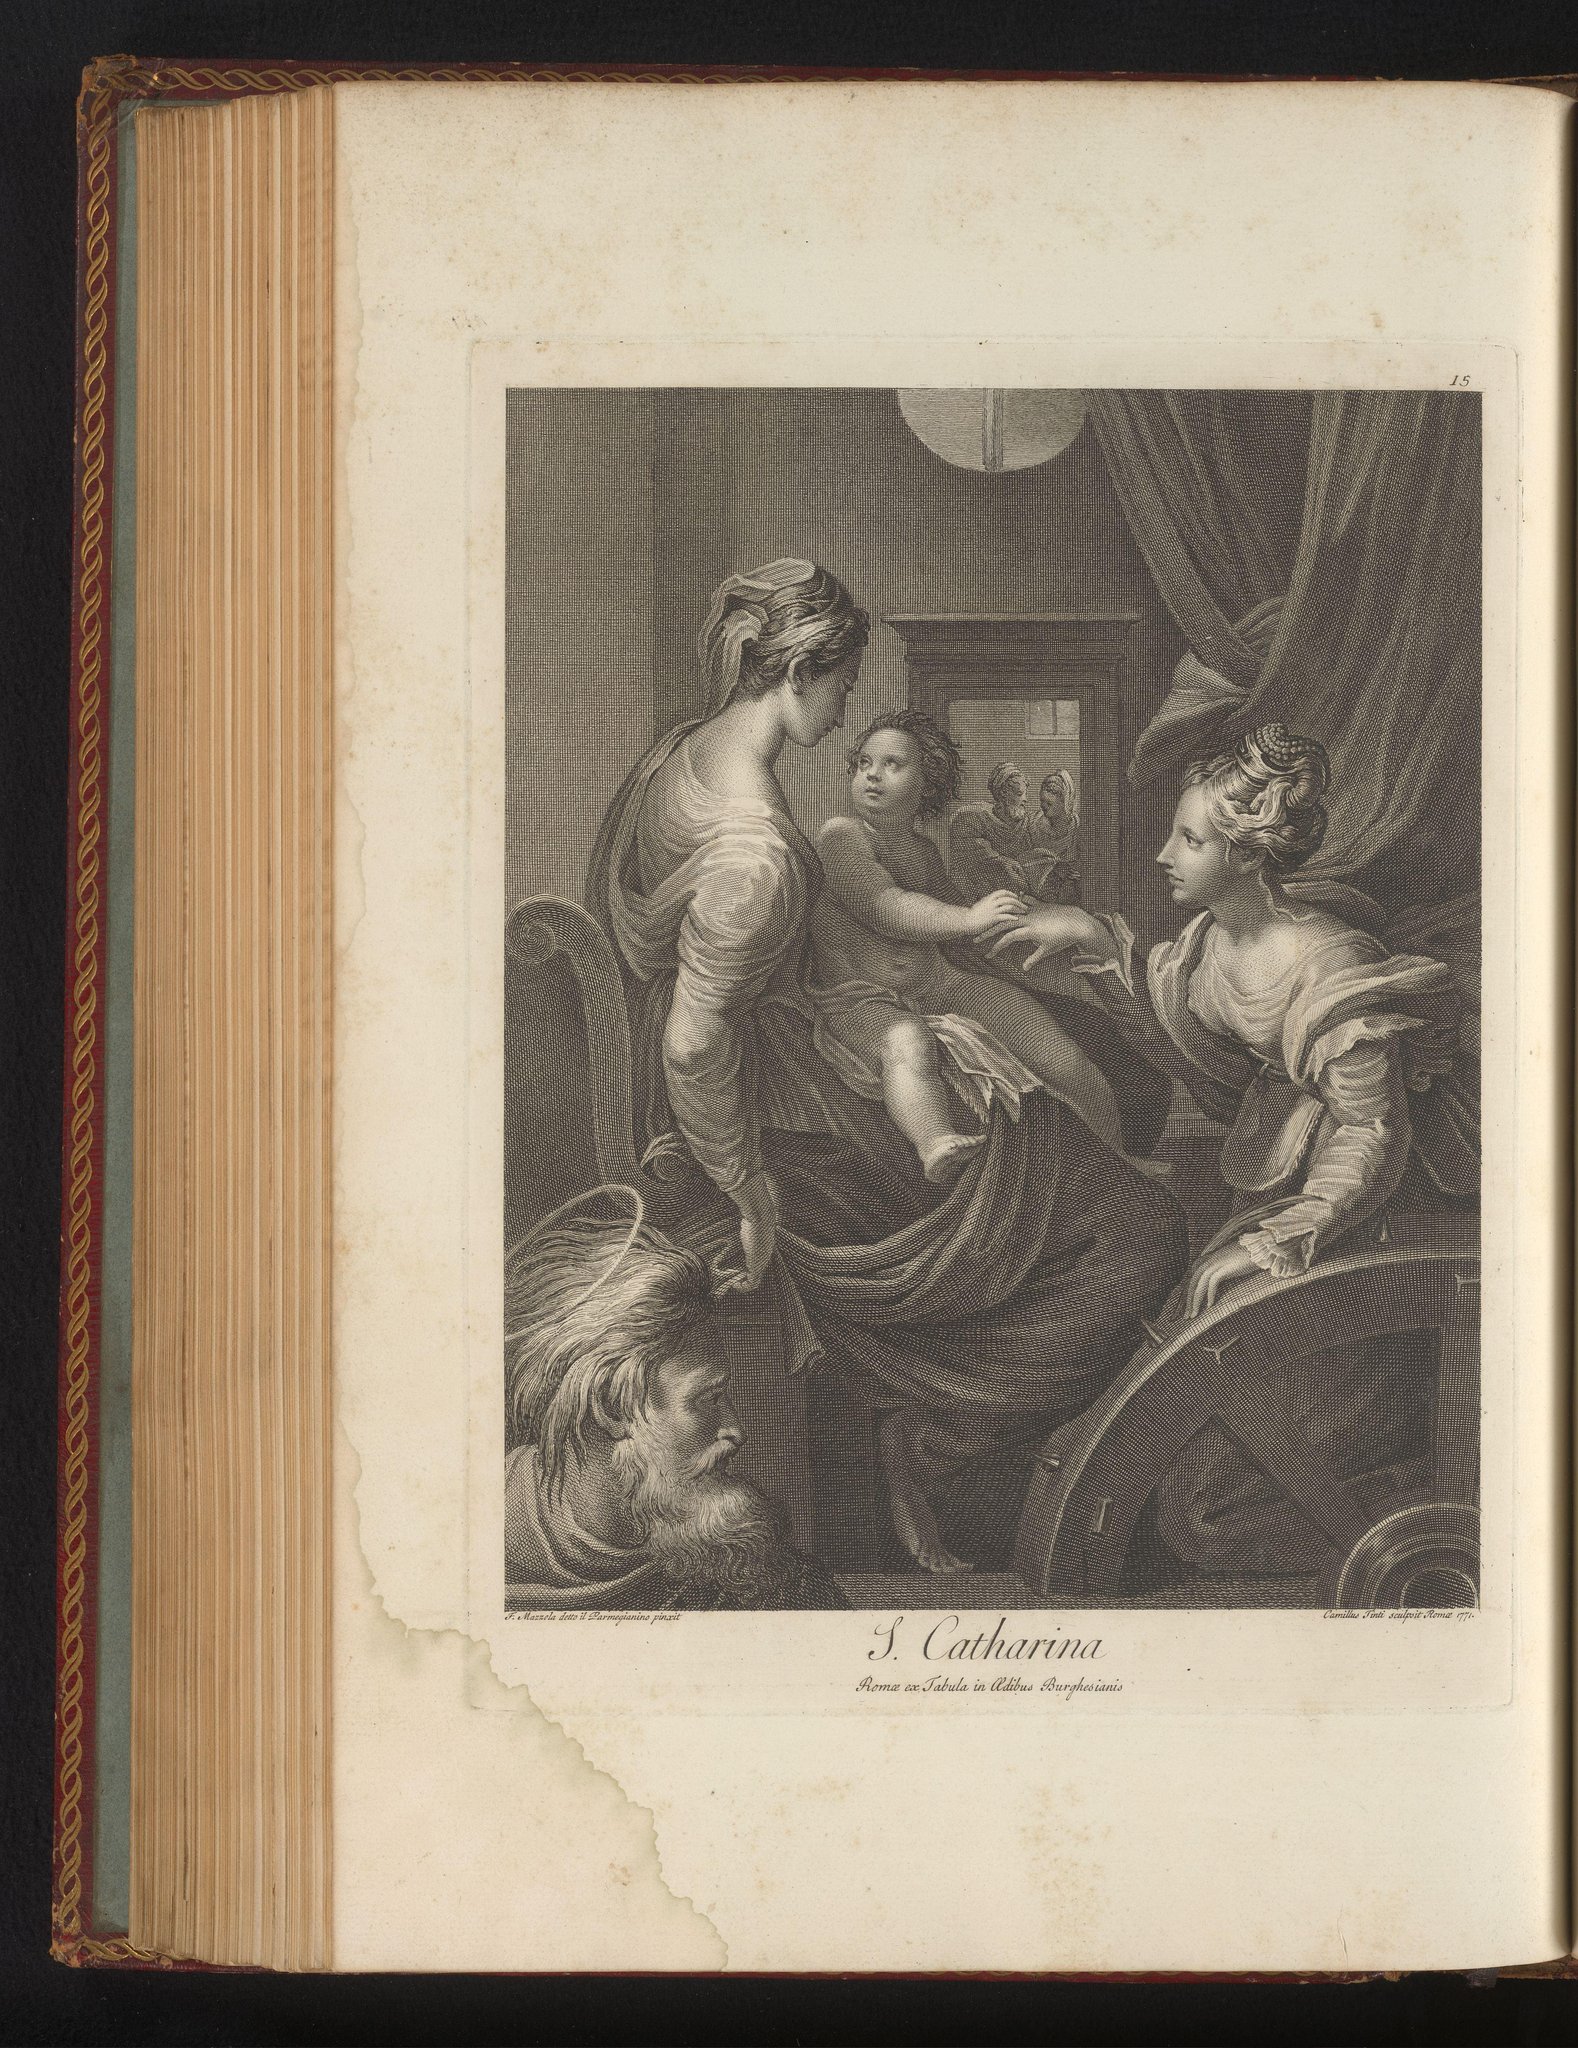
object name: album leaf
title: H. Catharina van Siena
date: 1771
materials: paper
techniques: engraving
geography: rome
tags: the virgin and dominican tertiary, catherine of siena; possible attributes: book, cross, crown of thorns, crucifix, demon under foot, heart (with cross), lily, plague-stricken, ring, rosary, stigmata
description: De samensteller heeft deze prent in het album gevoegd als illustratie bij: Pilkington, Matthew en Johann Heinrich Füssli. A dictionary of painters, from the revival of the art to the present period. 4 dln. Londen: John Crowder, 1805, dl. 2, p. 323.